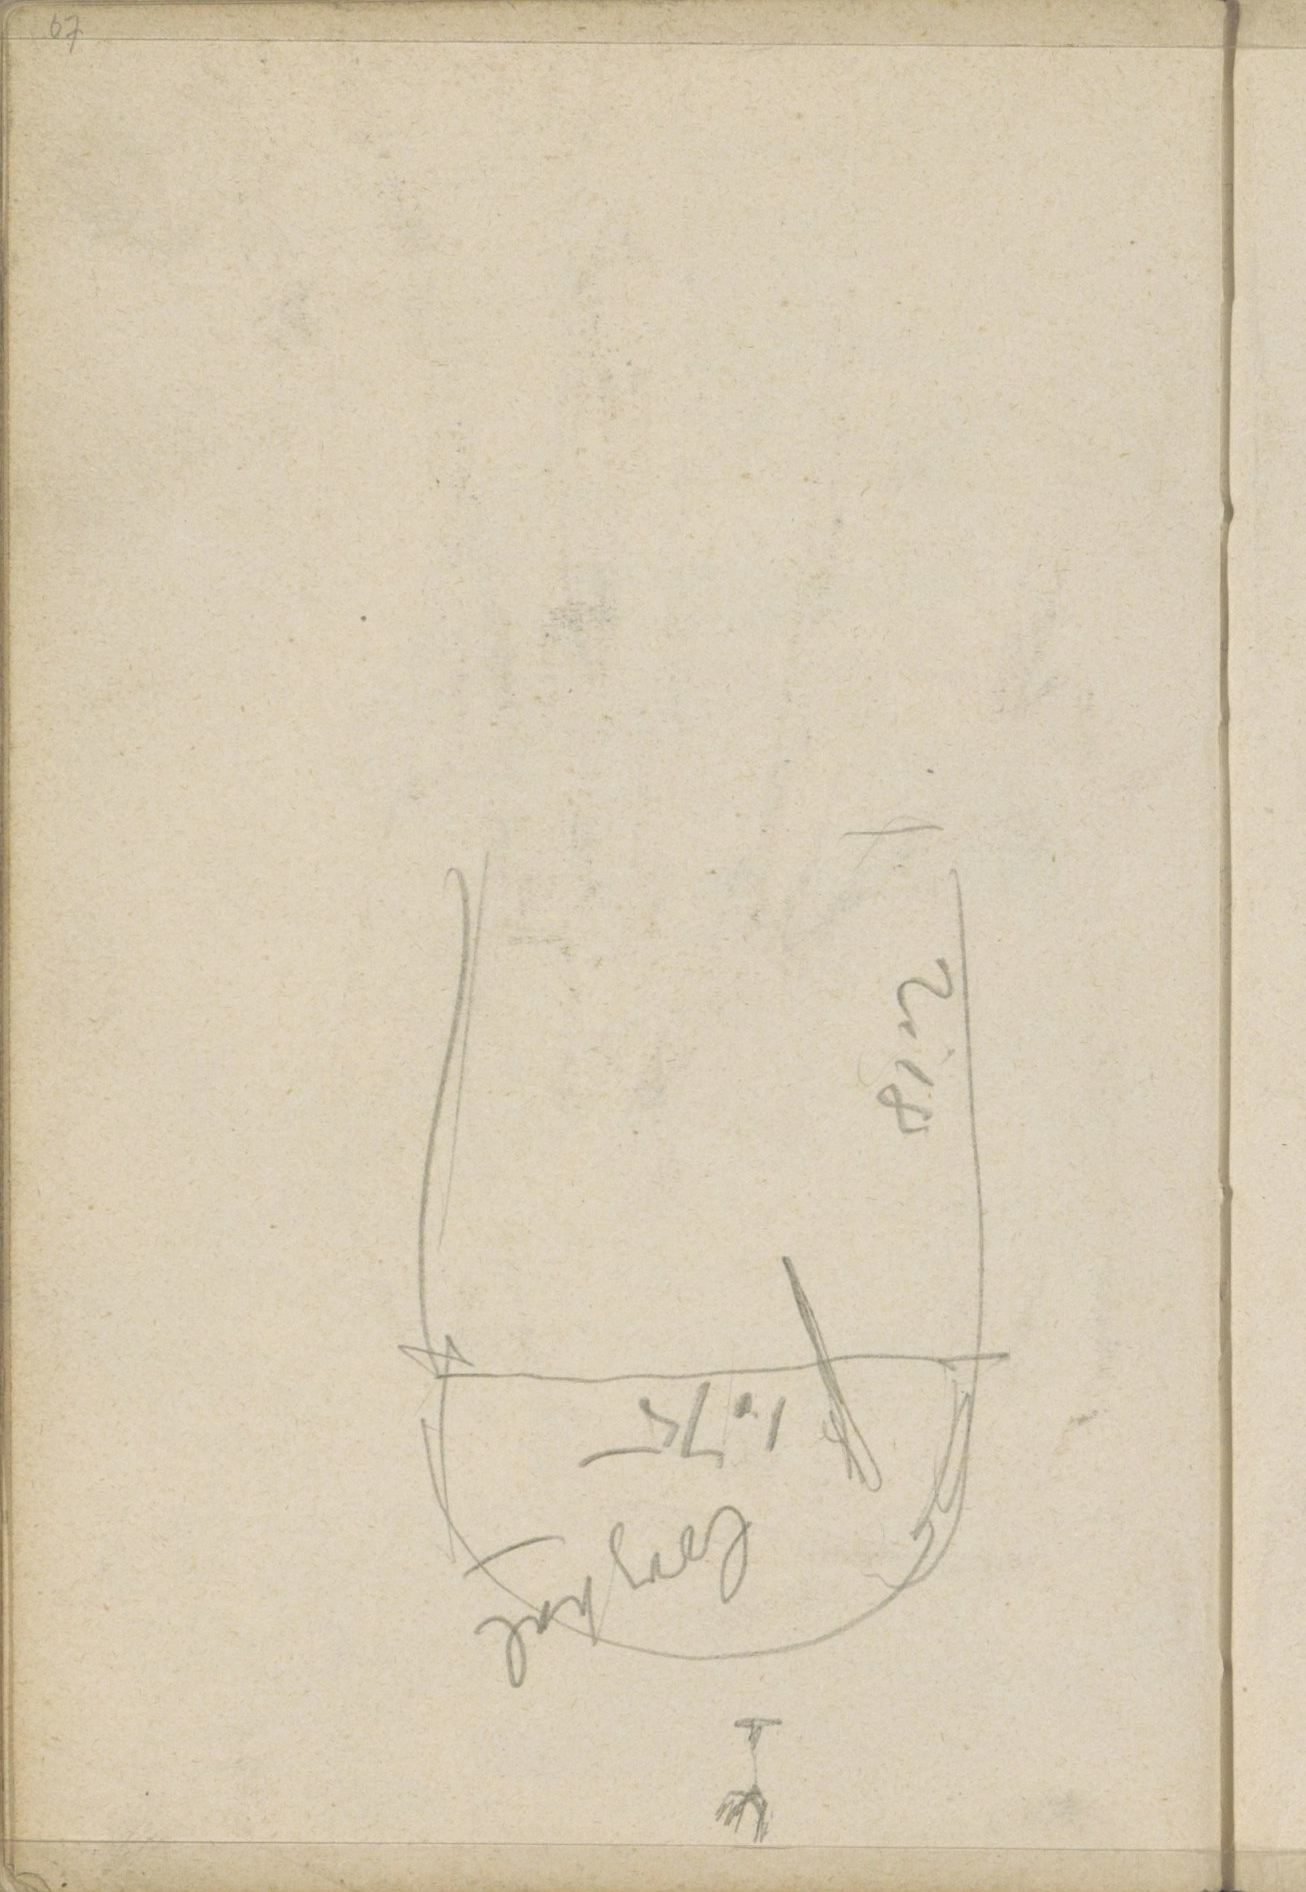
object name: sketchbook leaf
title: Boog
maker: george hendrik breitner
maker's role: draughtsman, painter, print maker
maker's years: 1857-1923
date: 1903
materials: paper, pencil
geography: amsterdam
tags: arch, archivolt ~ architecture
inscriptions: annotation: ‘boog hal’, annotation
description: Boog. Pagina 67 uit een schetsboek met 46 bladen.